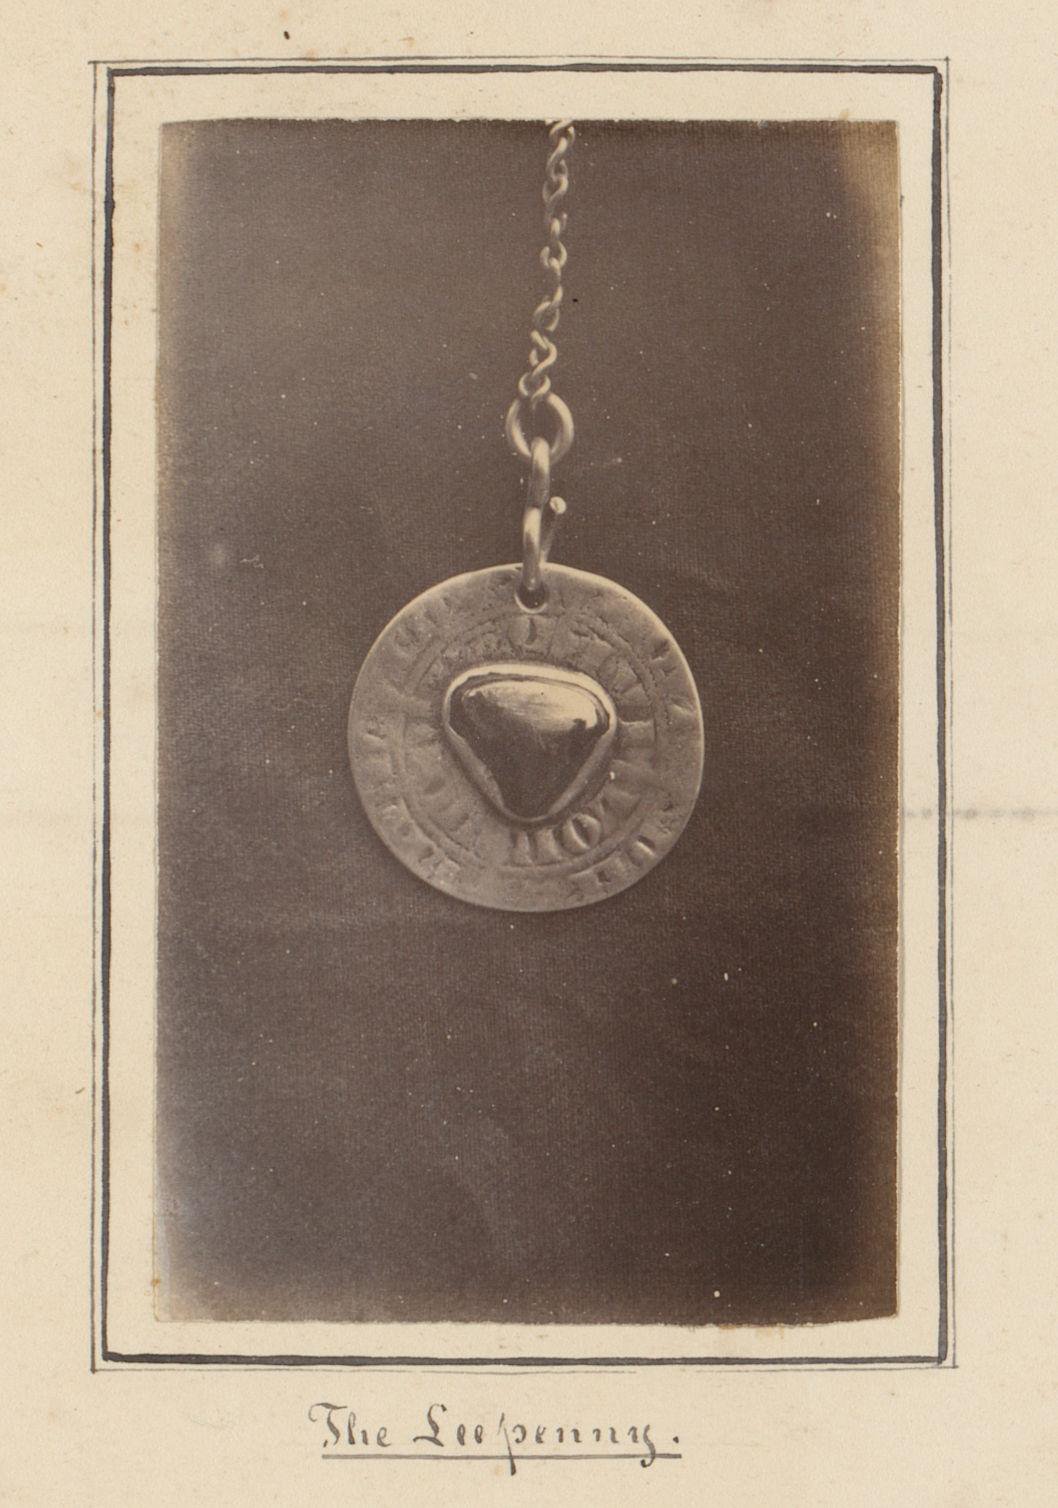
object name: photograph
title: The Leepenny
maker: Anonymous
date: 1870-1890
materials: paper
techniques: albumen print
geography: scotland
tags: amulet, talisman